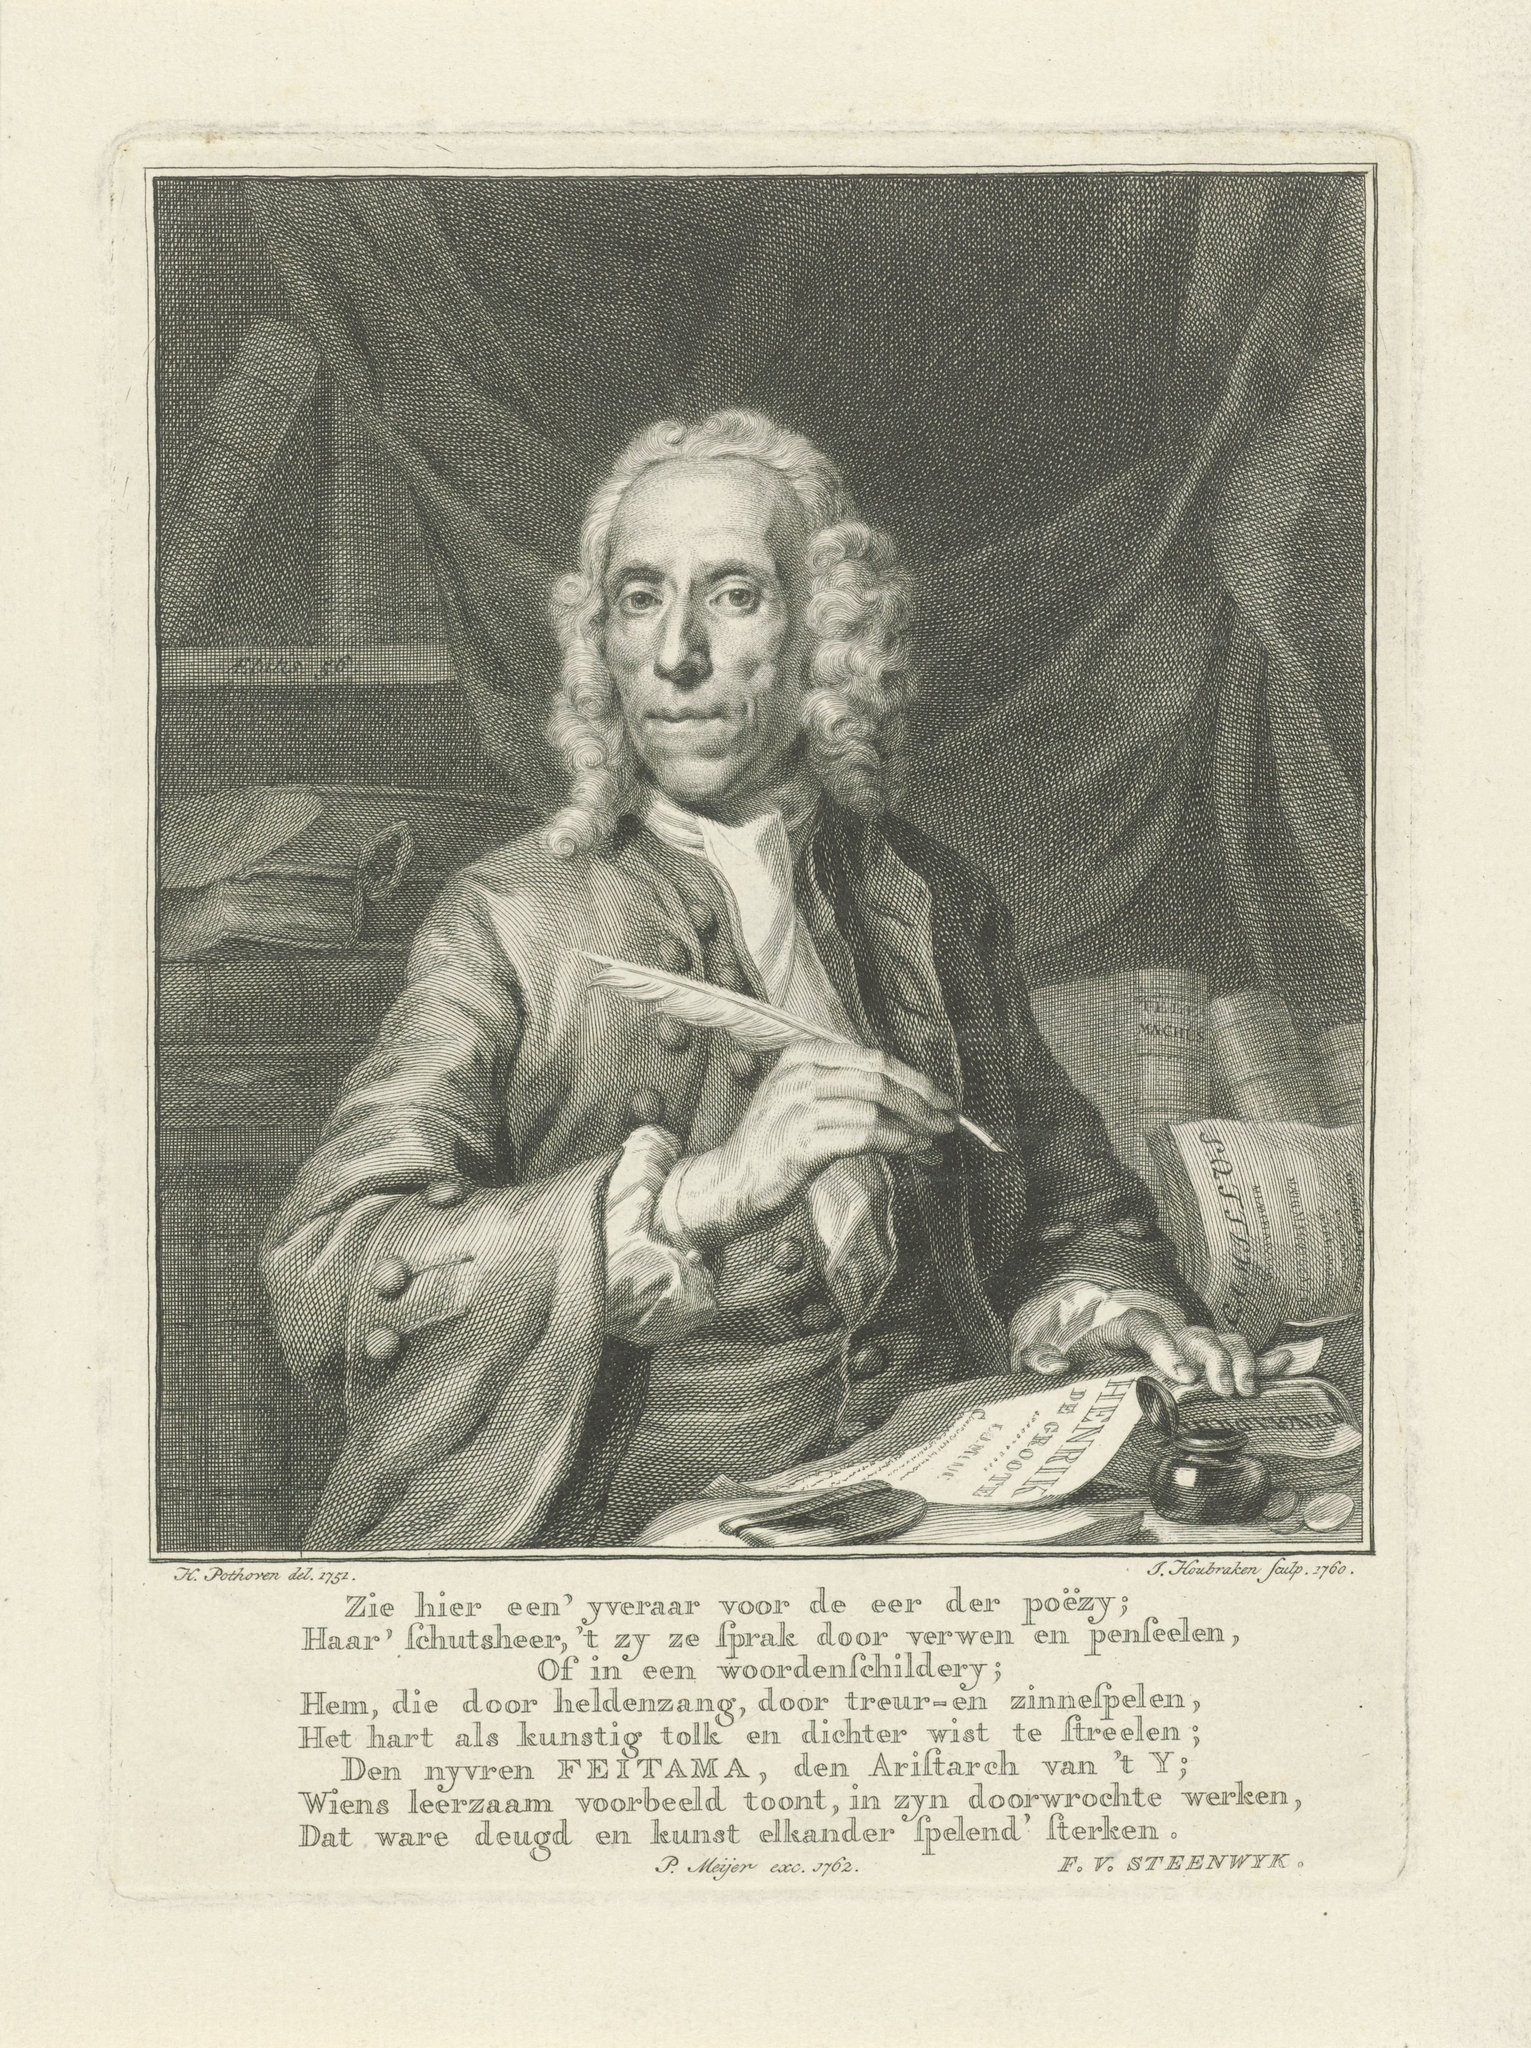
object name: print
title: Portret van Sybrand Feitama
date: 1762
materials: paper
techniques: engraving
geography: amsterdam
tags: draughtsman, sybrand feitama (ii), ink-well, study; 'studiolo'; library, writing accessories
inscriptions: collector's mark: Lugt 2228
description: Sybrand Feitama op 56-jarige leeftijd, zittend aan een tafel, een schrijfveer in zijn hand. Op de tafel papieren en een inktpot. Achter hem een gordijn en een boekenkast. Onder het portret een achtregelig vers in het Nederlands.